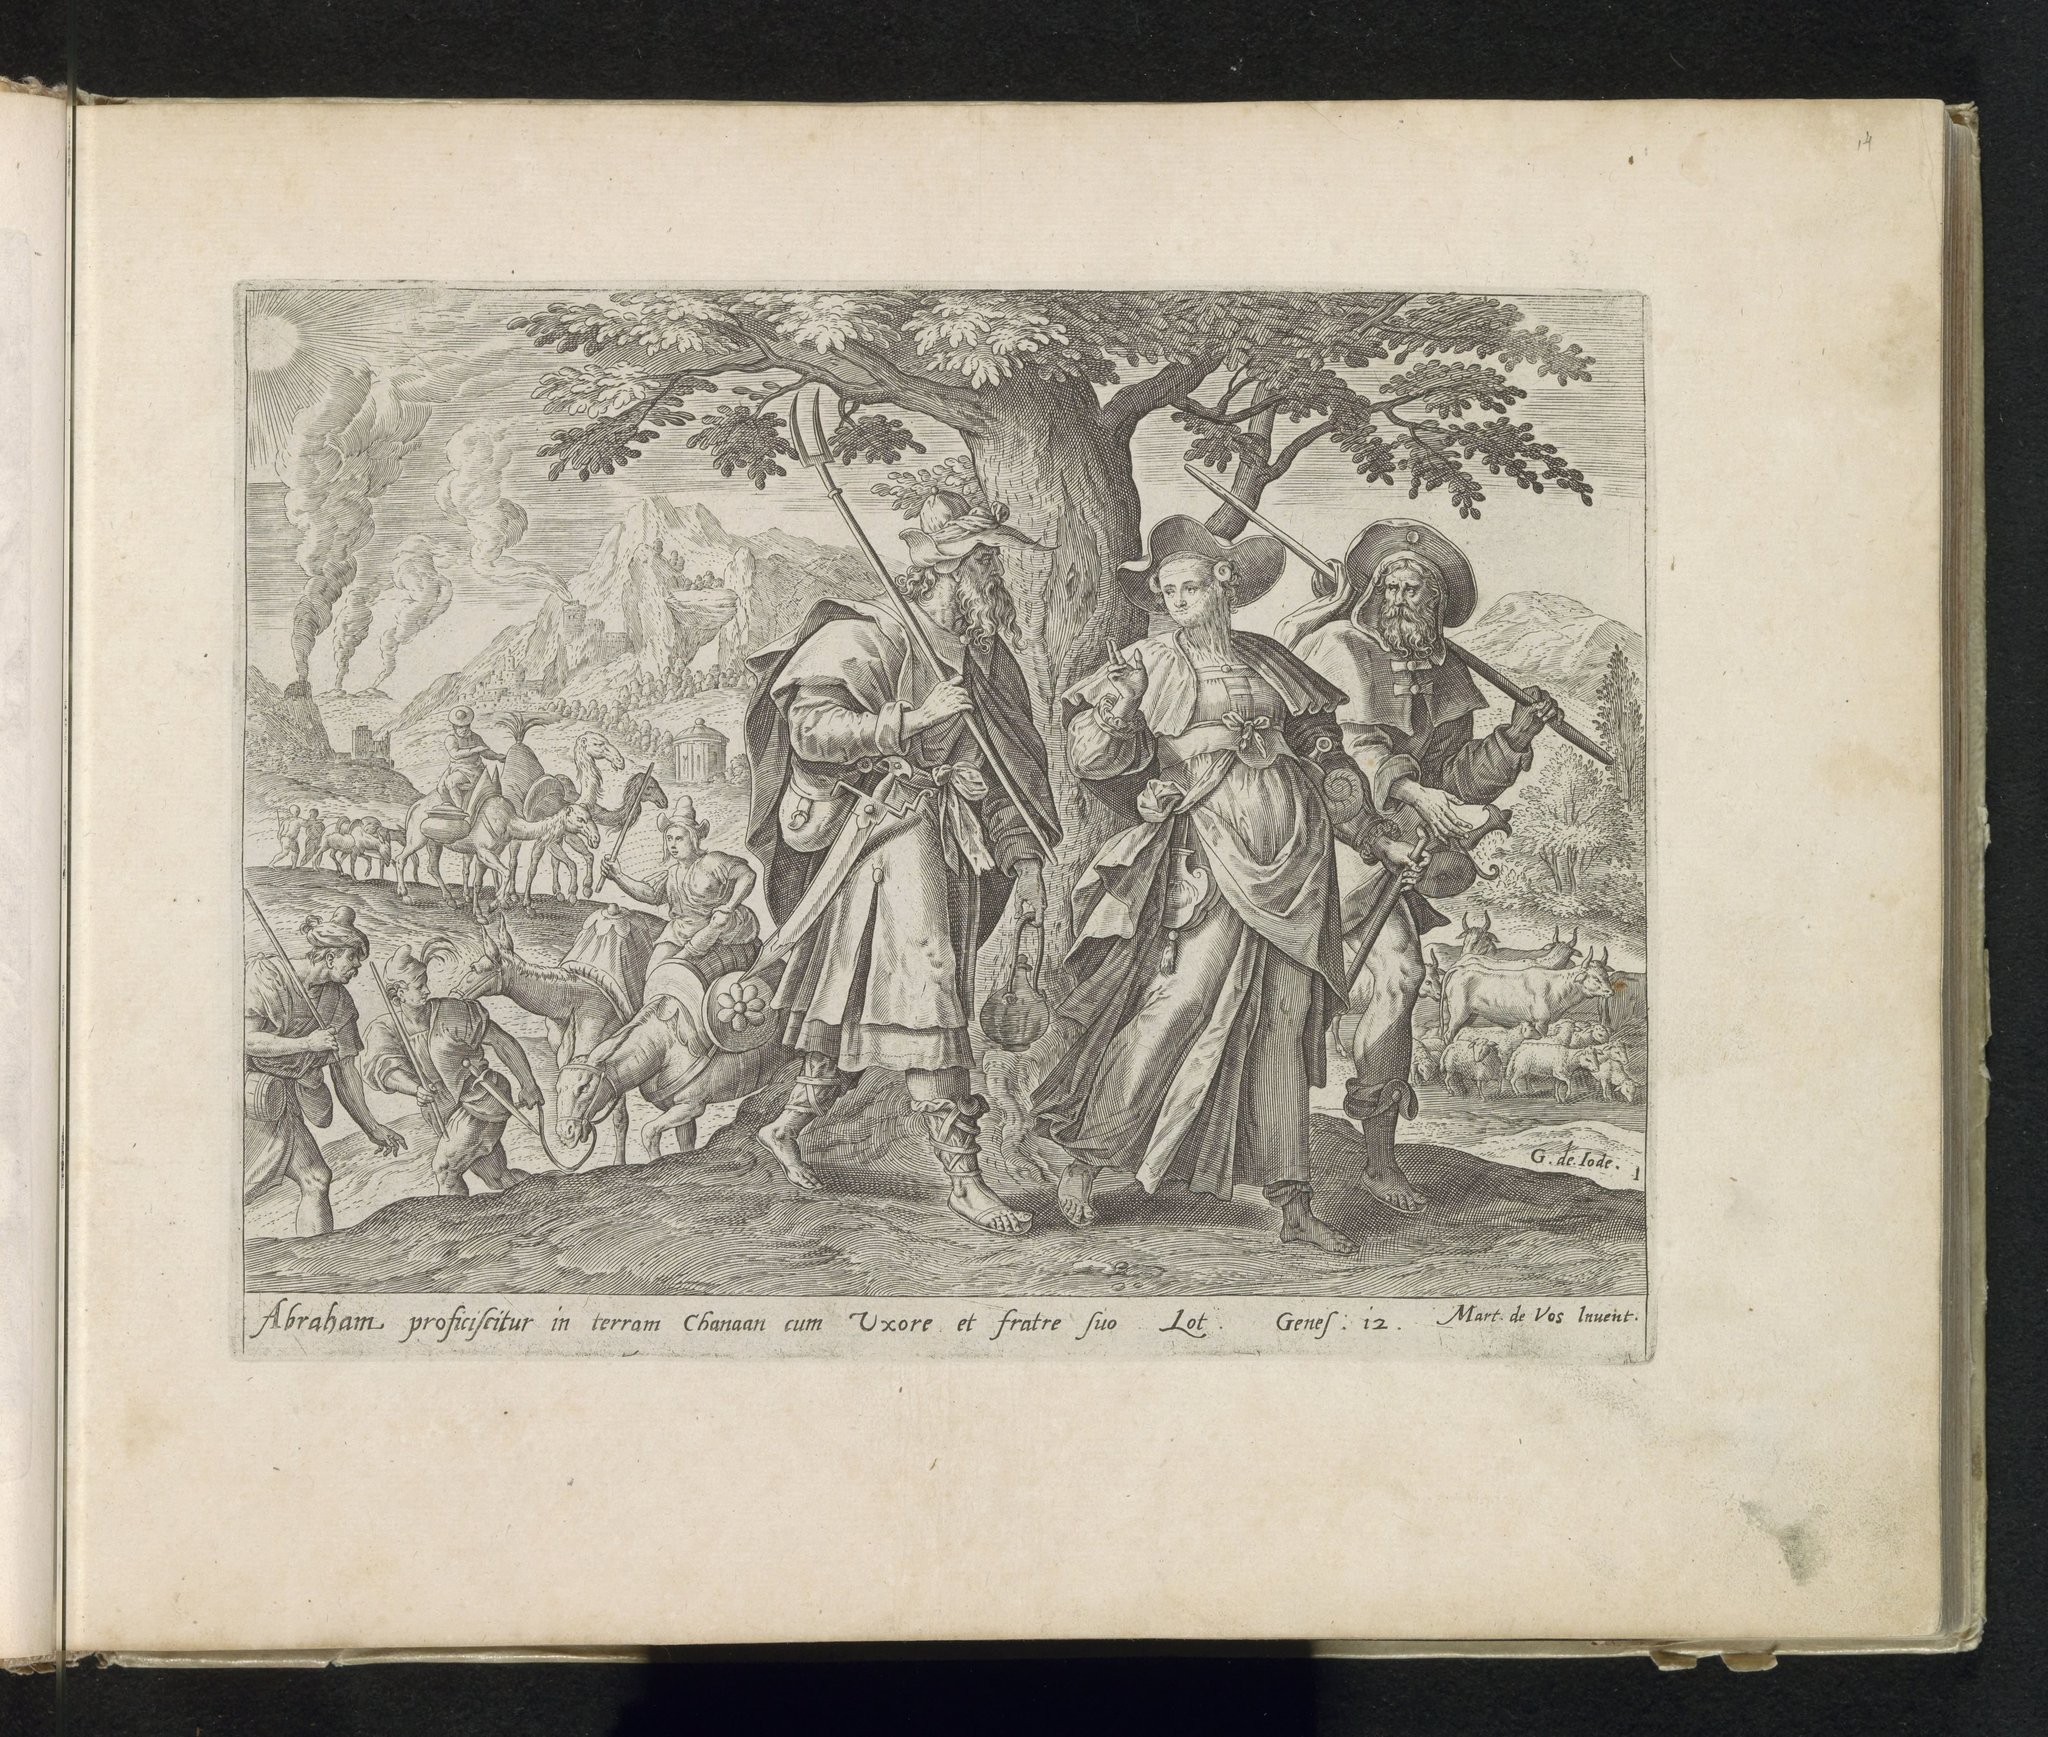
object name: print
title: Thesaurus sacrarum historiaru[m] veteris testame[n]ti, elega[n]tissimis imaginibus expressu[m] excelle[n]tissimoru[m] in hac arte viroru[m] opera: nu[n]c primu[m] in luce[m] editus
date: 1585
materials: paper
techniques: engraving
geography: antwerp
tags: abraham starts out for the land of canaan with sarah, lot and his belongings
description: Abraham vertrekt met zijn familie, tot slaaf gemaakte mannen en vrouwen en vee naar Kanaän. Op de voorgrond in het landschap lopen Abraham, zijn vrouw Sara en zijn neef Lot. Onder de voorstelling een verwijzing in het Latijn naar de Bijbeltekst in Gen. 12. Deze prent maakt deel uit van een album.